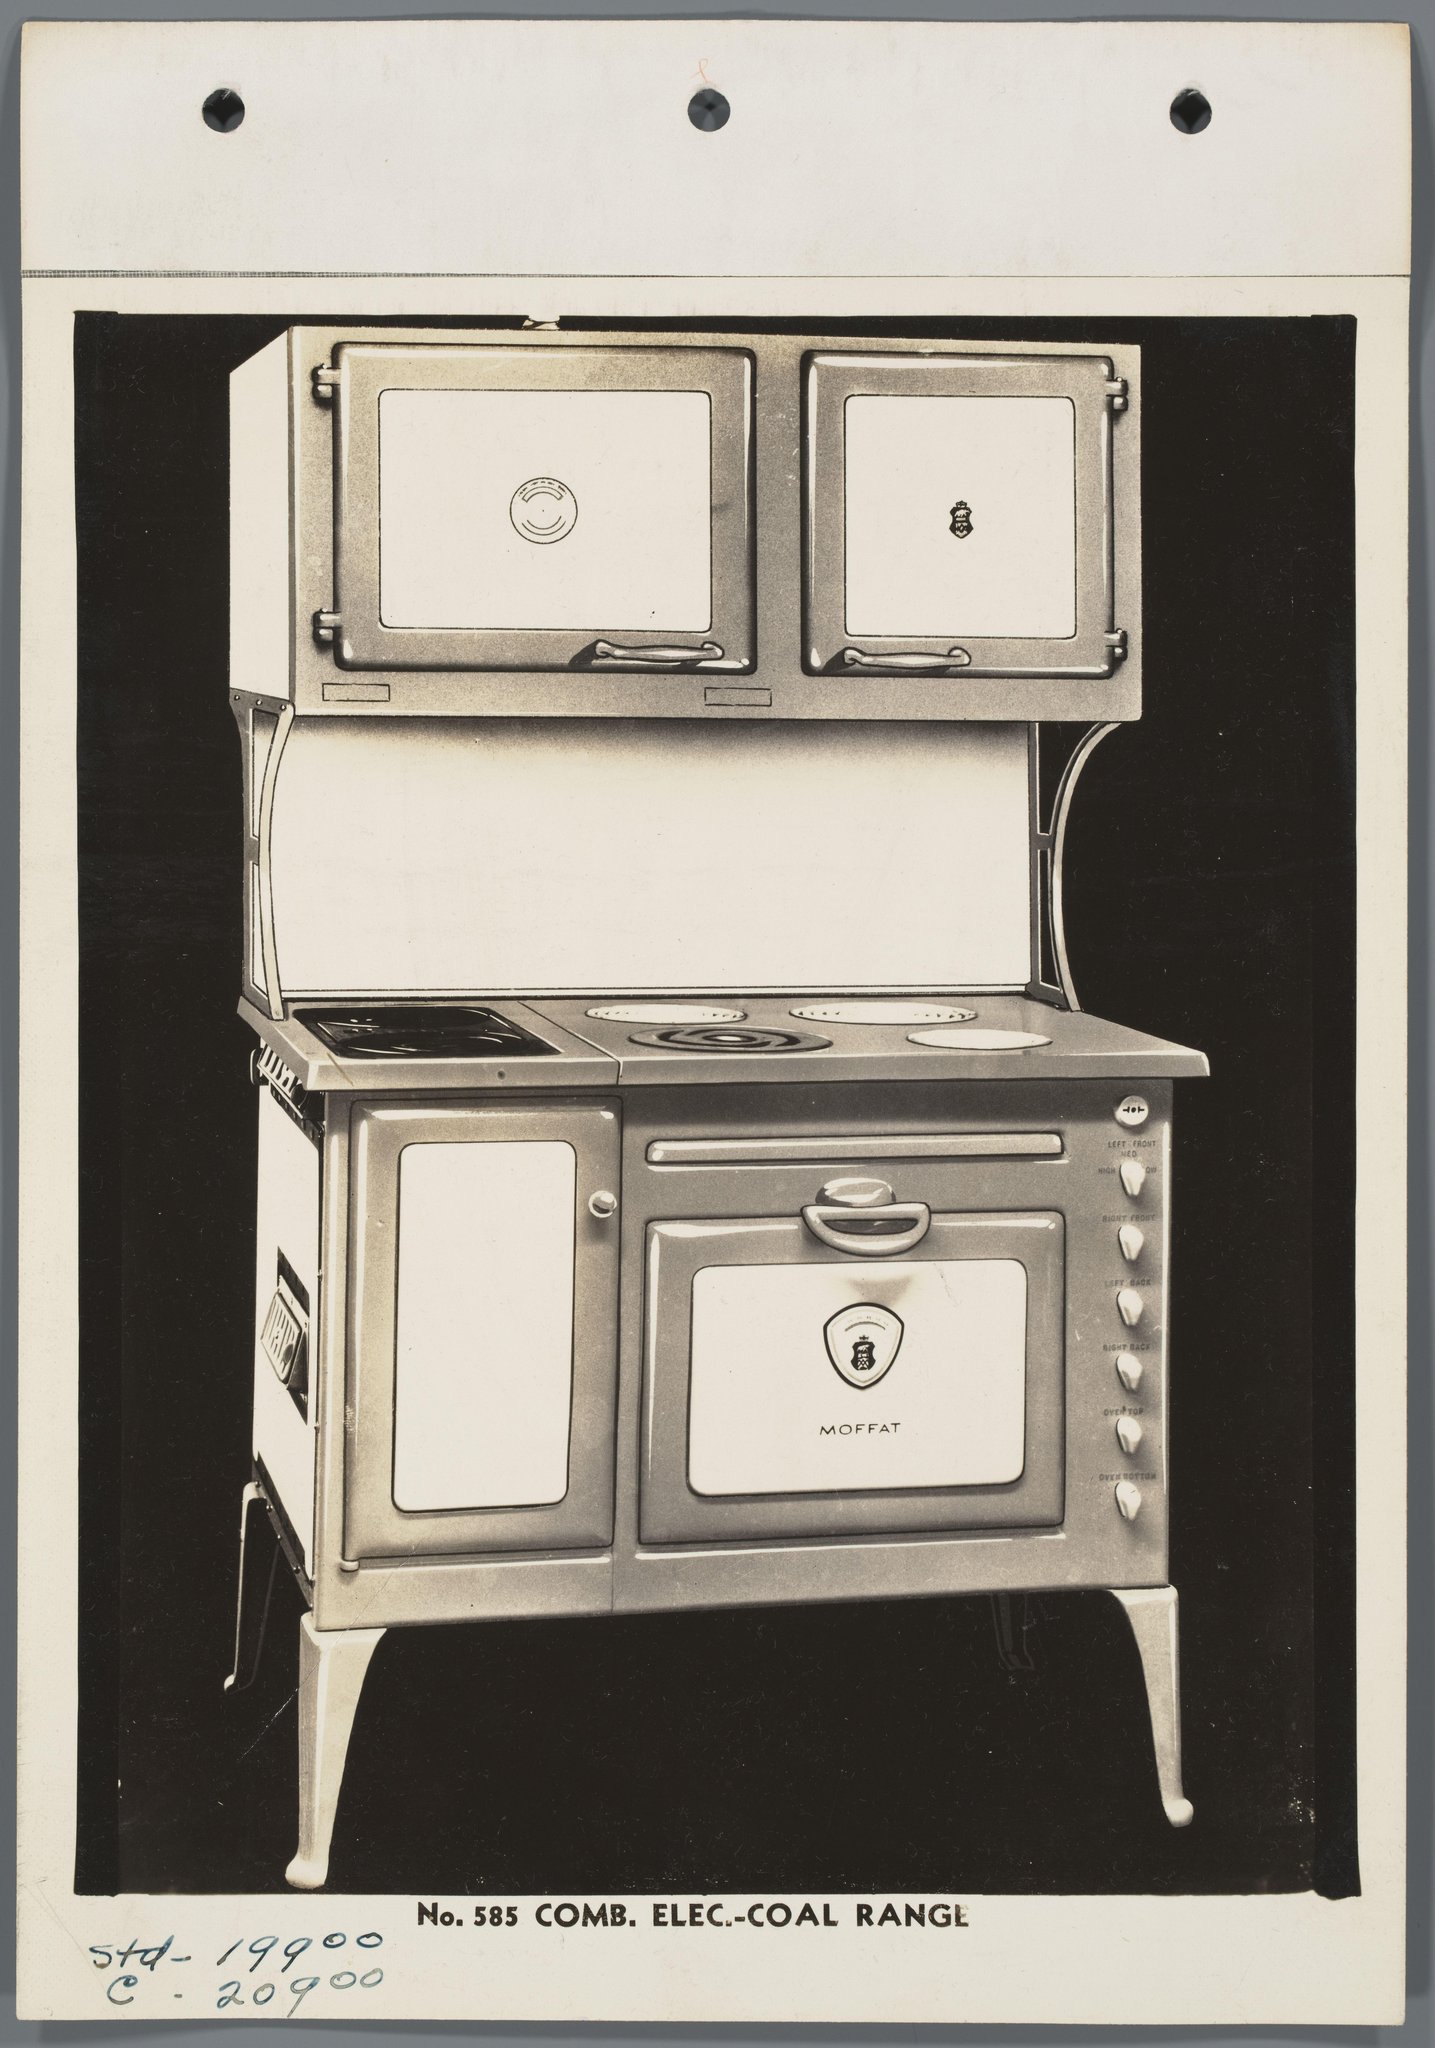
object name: photograph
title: Foto van Moffat ovens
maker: Anonymous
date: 1935-1940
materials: paper, photographic support, textile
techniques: gelatin silver print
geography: canada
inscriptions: inscription: ‘No. 585 COMB. ELEC.-COAL RANGE’, inscription: ‘std-19900, C 20900’